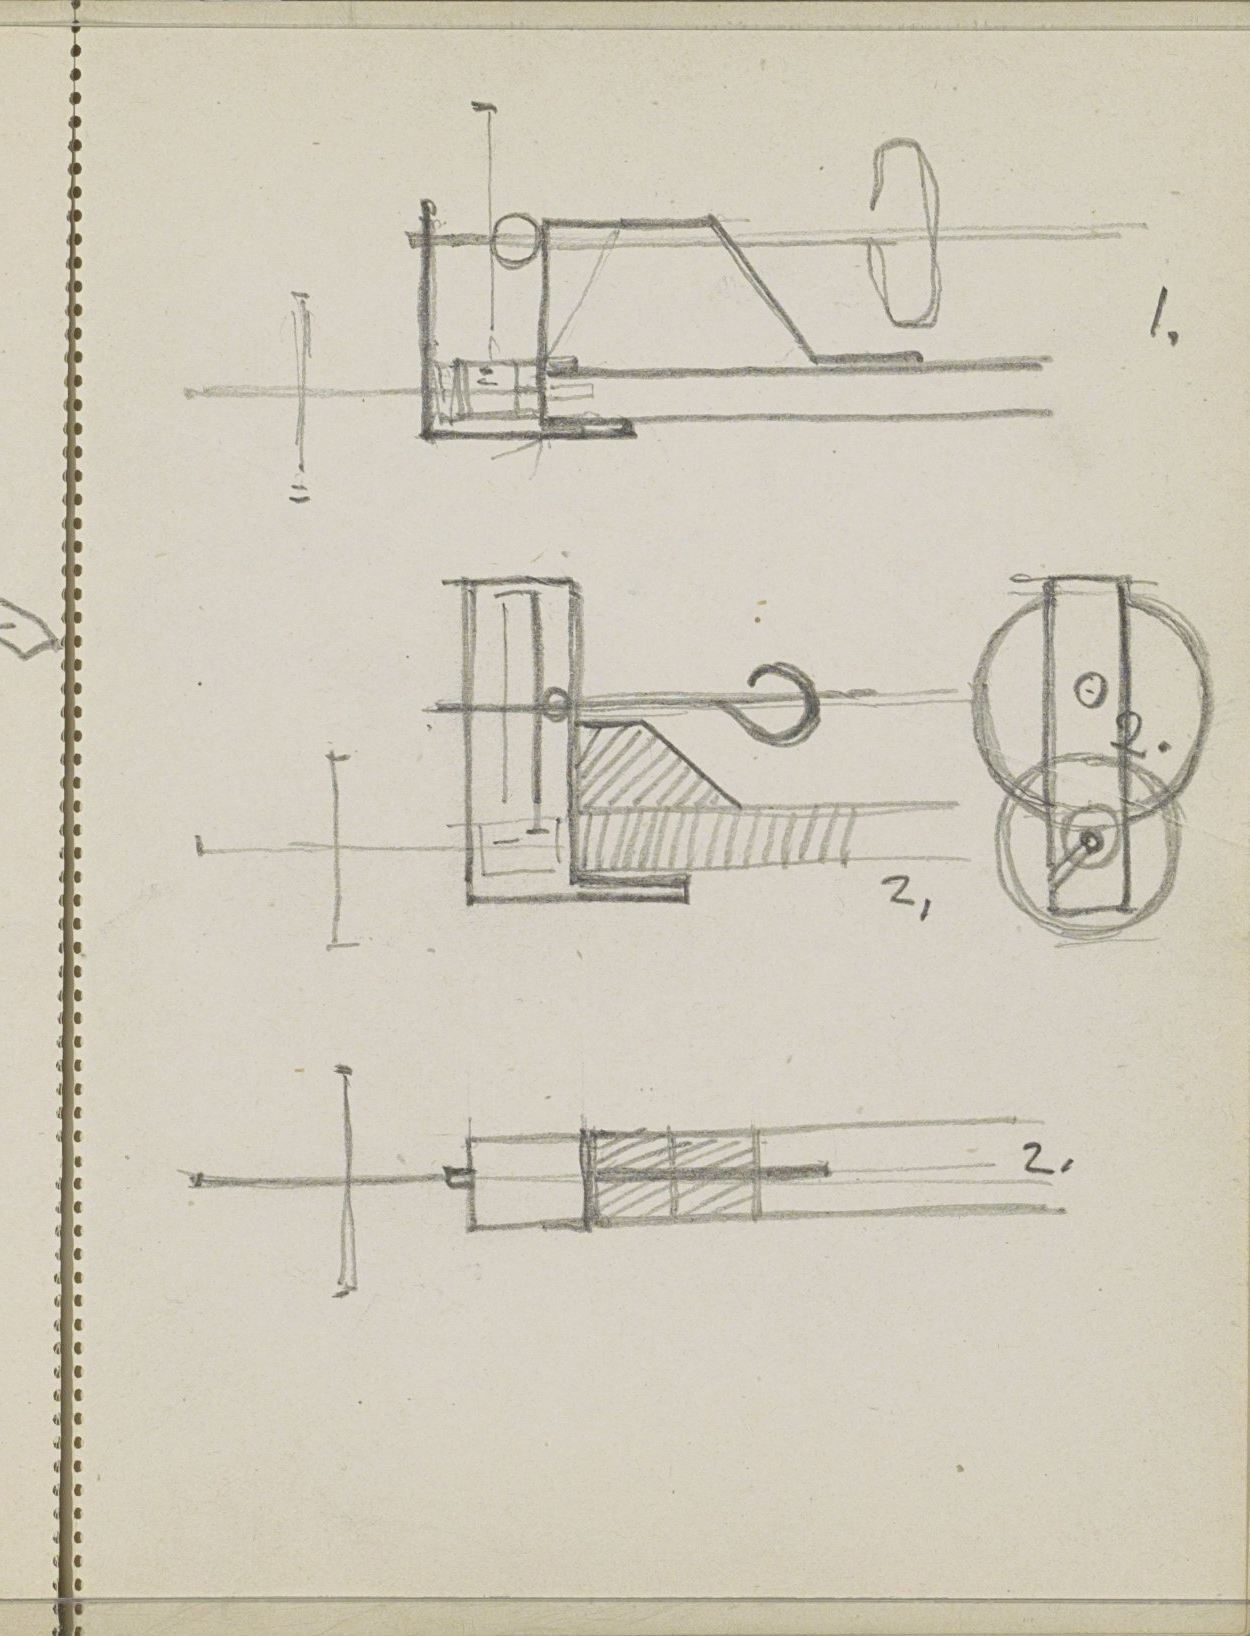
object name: sketchbook leaf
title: Ontwerp voor een machine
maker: reijer stolk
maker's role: draughtsman, print maker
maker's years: 1896-1945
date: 1906-1945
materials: paper, pencil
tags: design, plan (~ production)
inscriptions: number: ‘[...]’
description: Vermoedelijk een vliegmachine. Blad 36 recto uit een schetsboek met 53 bladen.